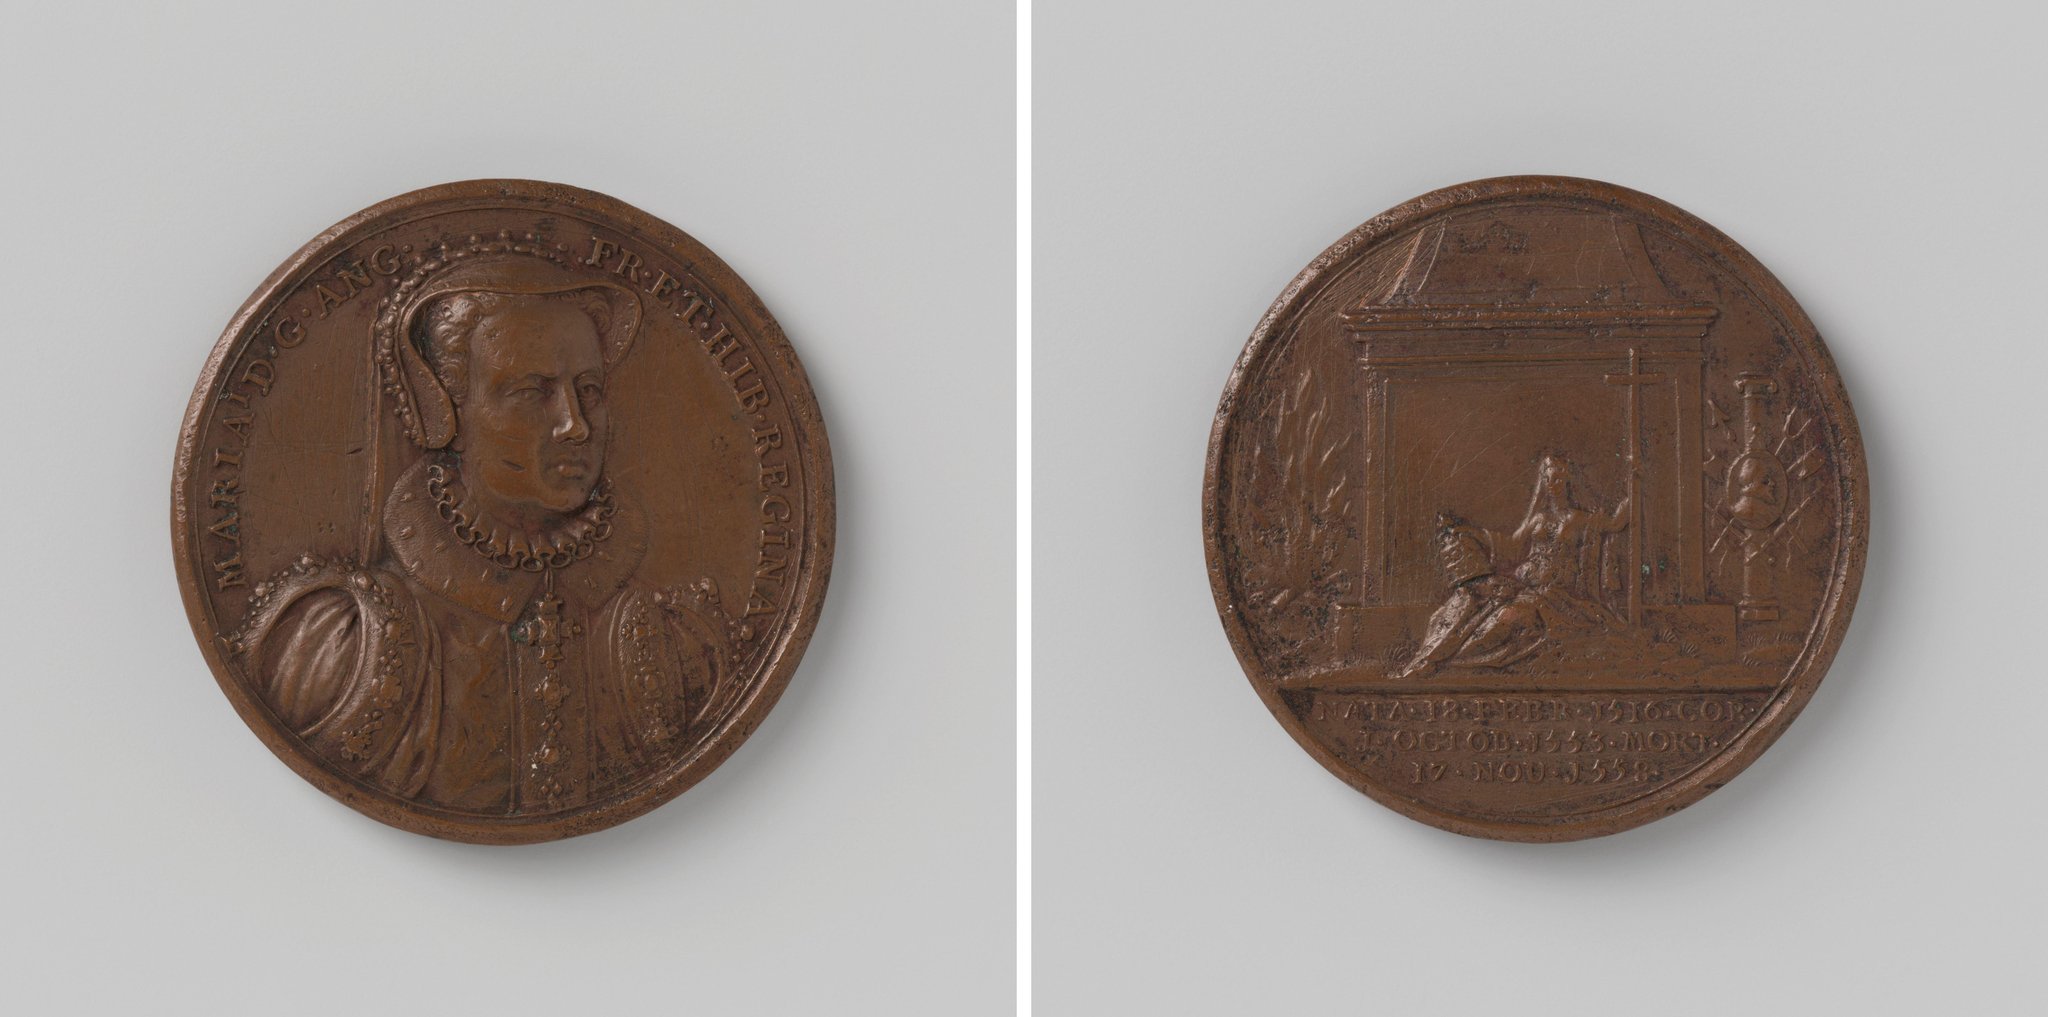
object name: history medal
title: Overlijden van Maria I, koningin van Engeland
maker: jean dassier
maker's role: medailleur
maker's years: 1676-1763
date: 1731-1732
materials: bronze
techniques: striking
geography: geneva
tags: london